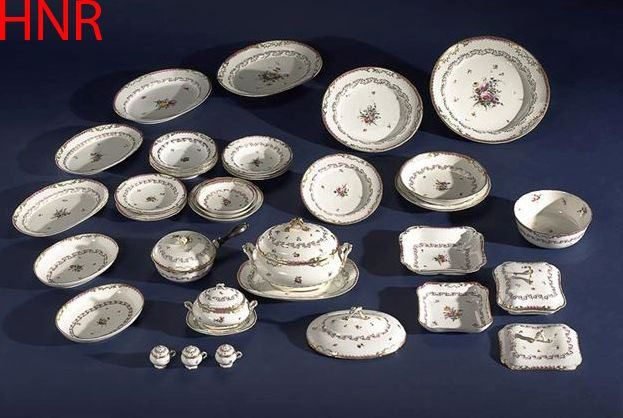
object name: plate dish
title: Bord, diep model, behorend bij een servies met geslingerd lintmotief met bladertakken, bloemboeketten en gestrooide bloemtakken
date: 1780-1820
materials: porcelain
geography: loosdrecht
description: Bord, diep model, behorend bij een servies van porselein met geslingerd lintmotief in paars en goud met groene bladertakken, bloemboeketten en gestrooide bloemtakken. Randen lichtgegolfd met decoratie in goud met paars bladmotief waartussen groen gekruist bladmotief. Gemerkt: M.O.L. en Amstel. Serie van vijftien stuks.